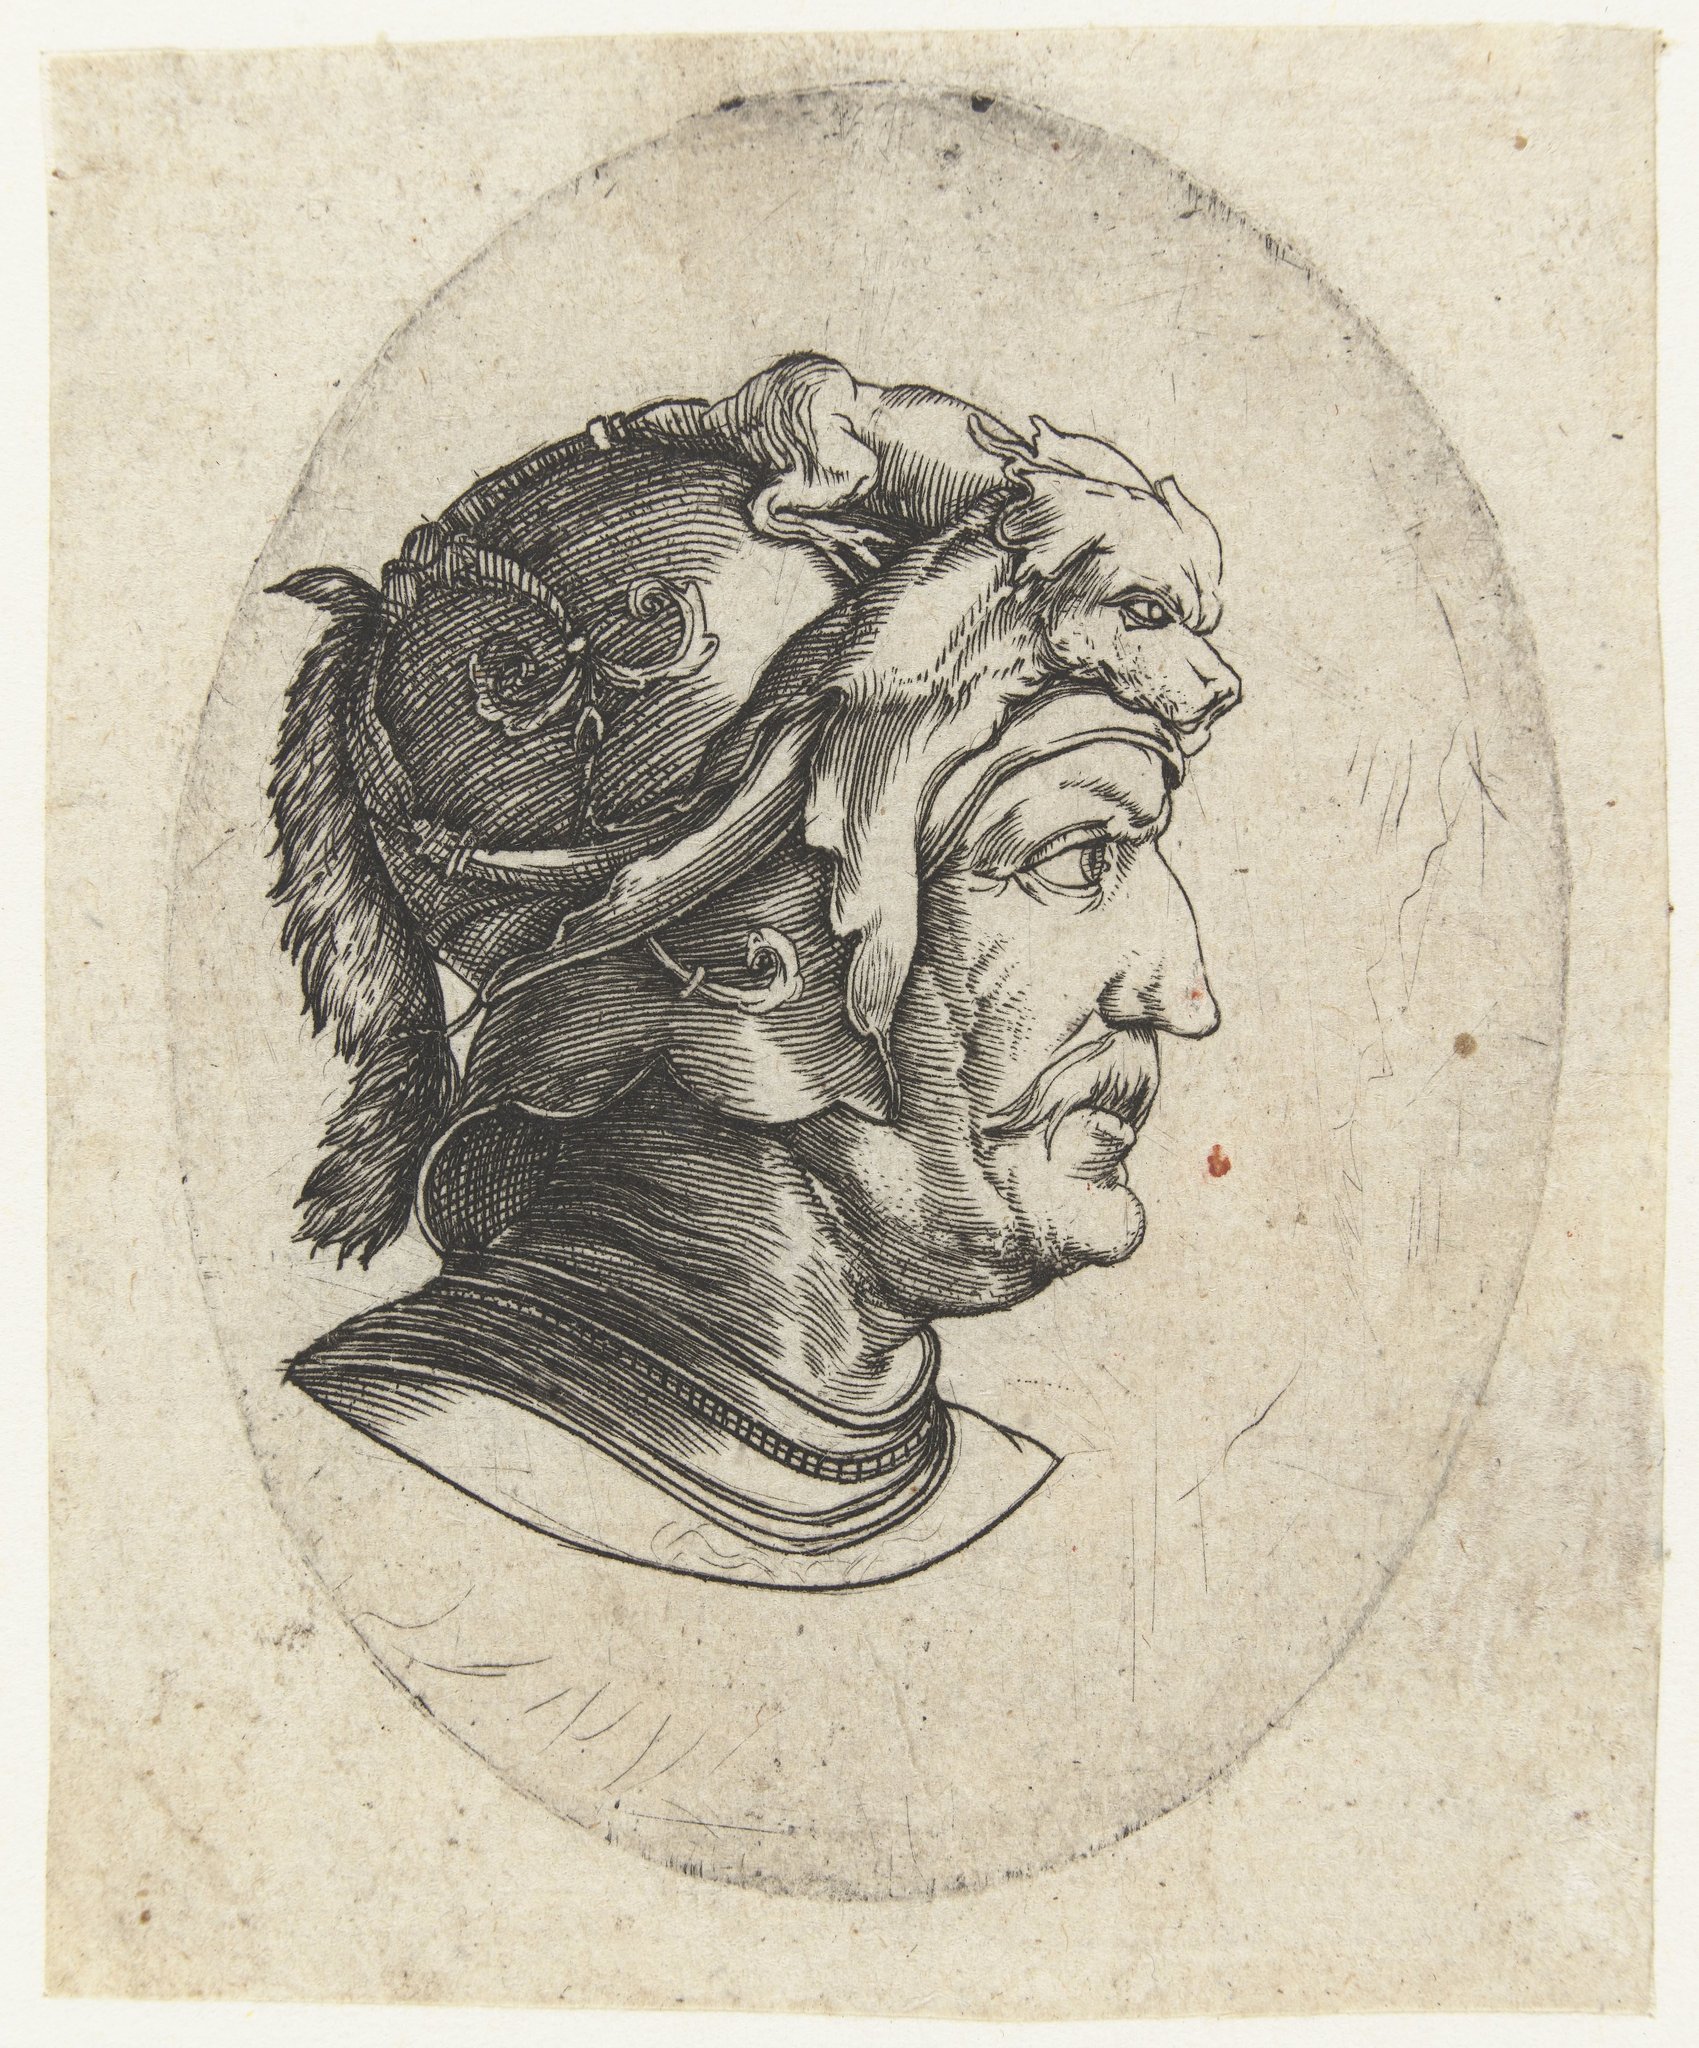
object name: print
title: Kop van een soldaat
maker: Anonymous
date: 1527-1583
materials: paper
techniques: engraving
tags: head (human), ornament derived from plant forms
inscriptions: collector's mark: Lugt 240, collector's mark: Lugt 2228a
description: Kopie in spiegelbeeld, alleen kop van soldaat.